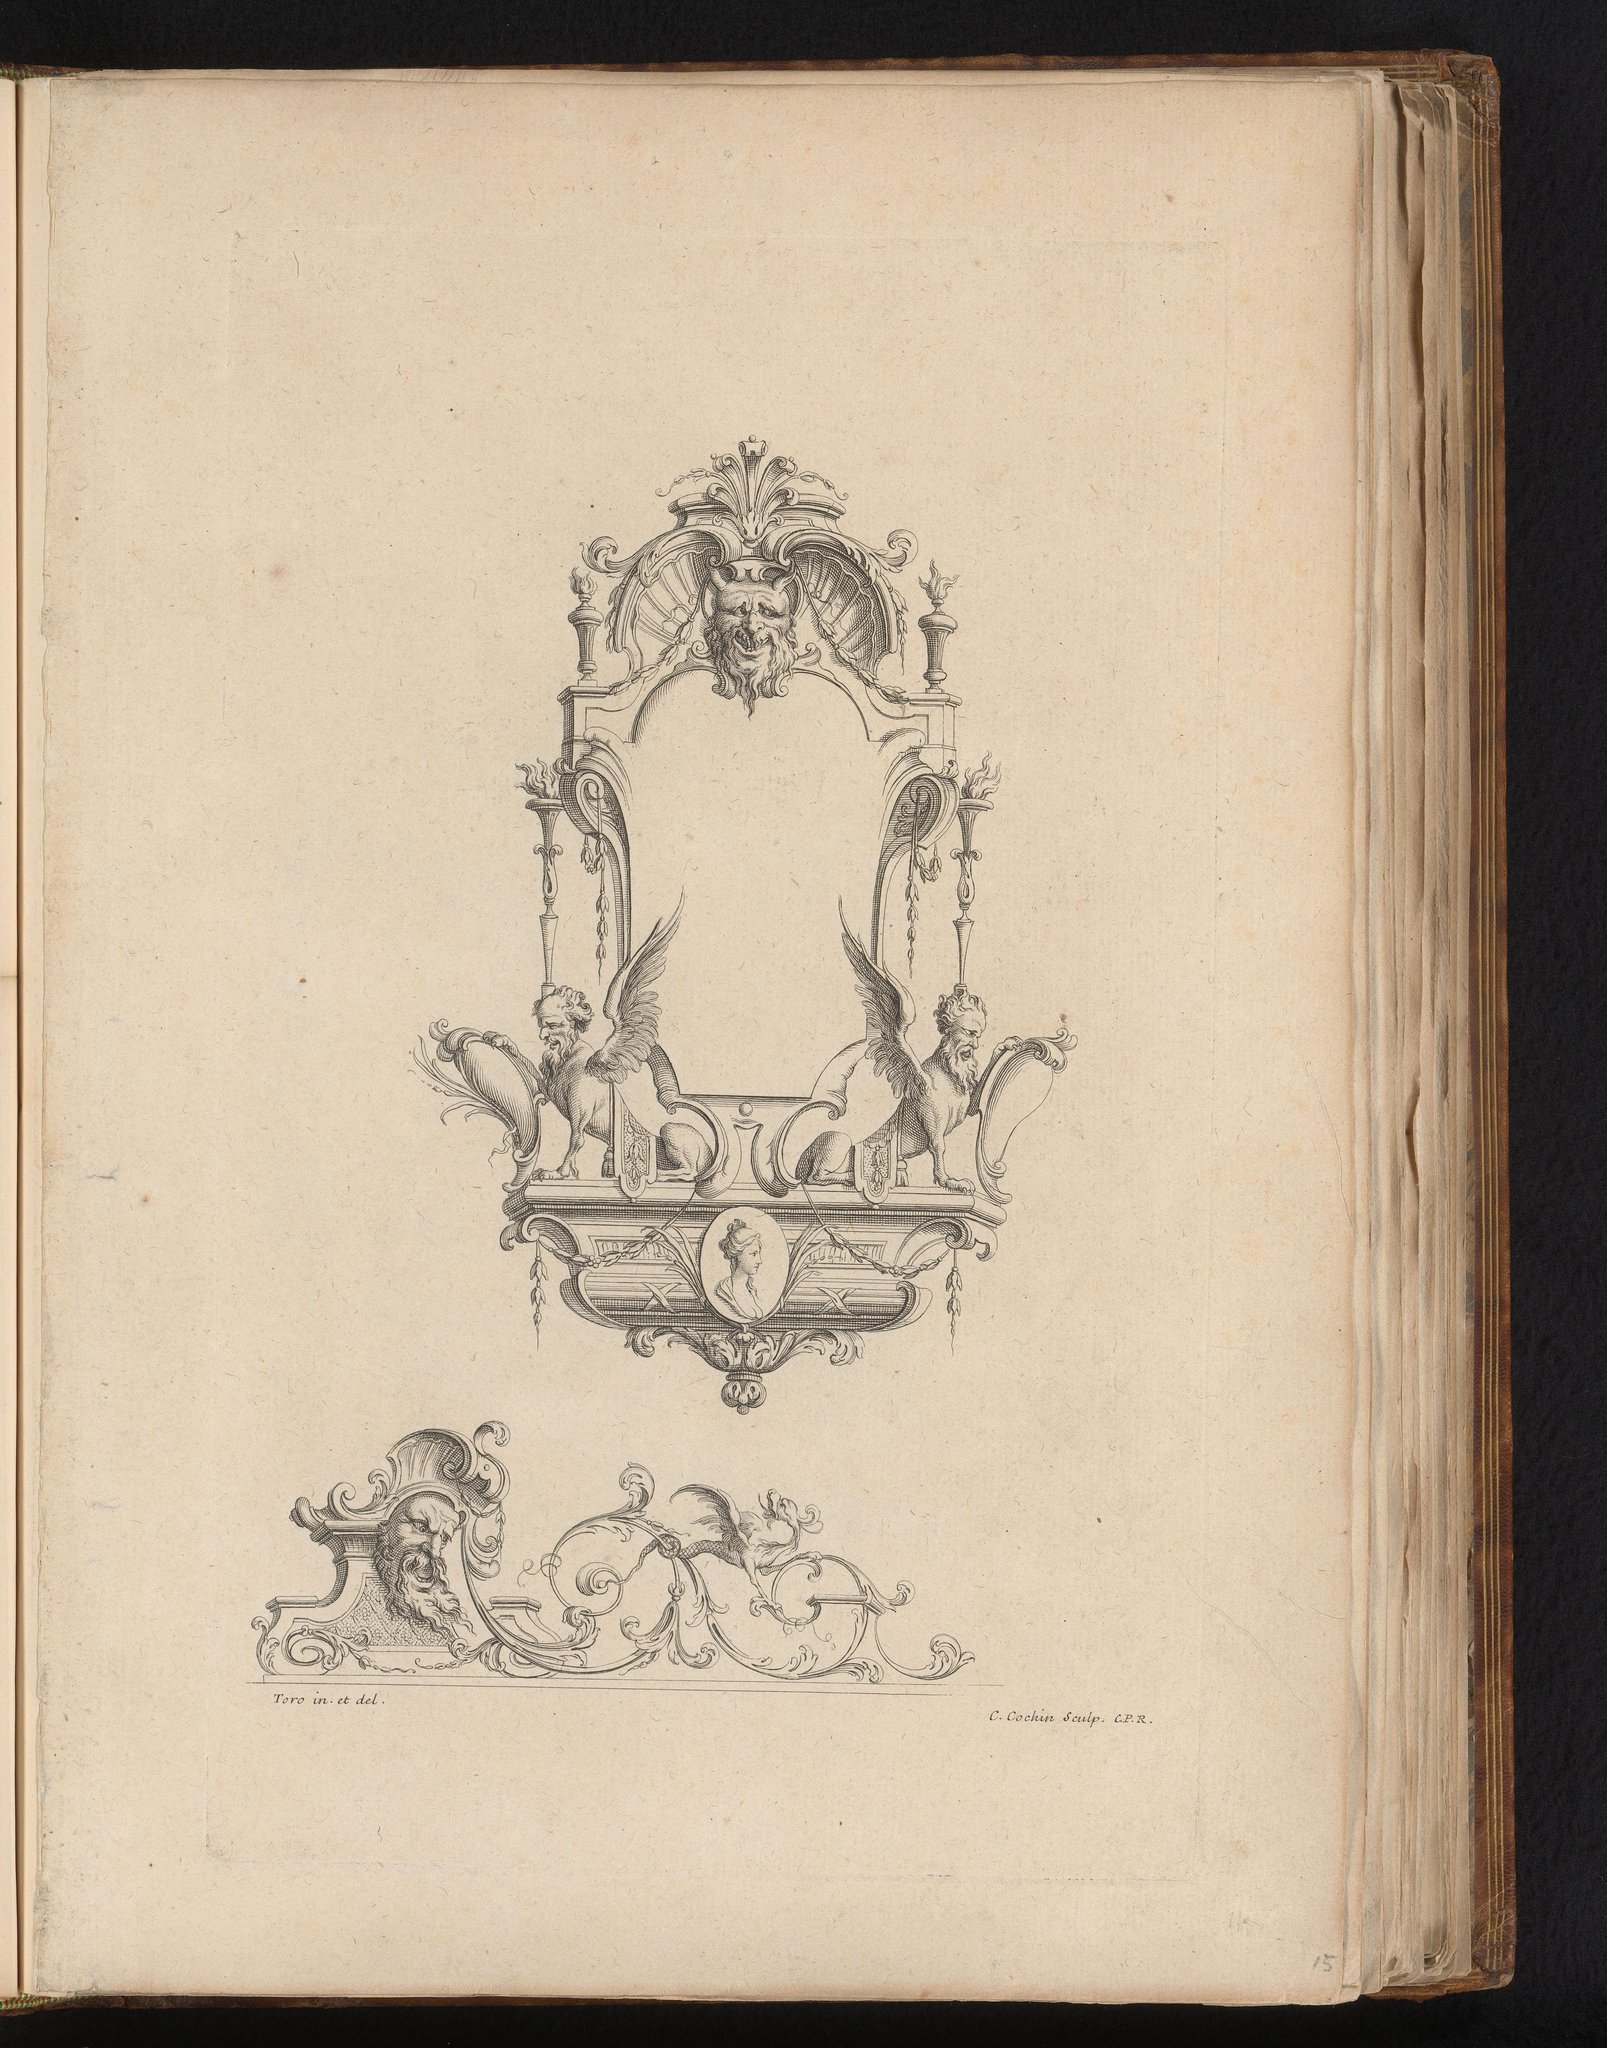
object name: print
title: Cartouche met mannelijke sfinxen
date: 1698-1731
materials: paper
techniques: engraving, etching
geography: paris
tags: ornament ~ cartouche, monsters ~ predatory animals (sphinx, 'manticora')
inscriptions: collector's mark: Lugt 2760, collector's mark: Lugt 2228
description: Prent maakt deel uit van een serie van zes prenten.